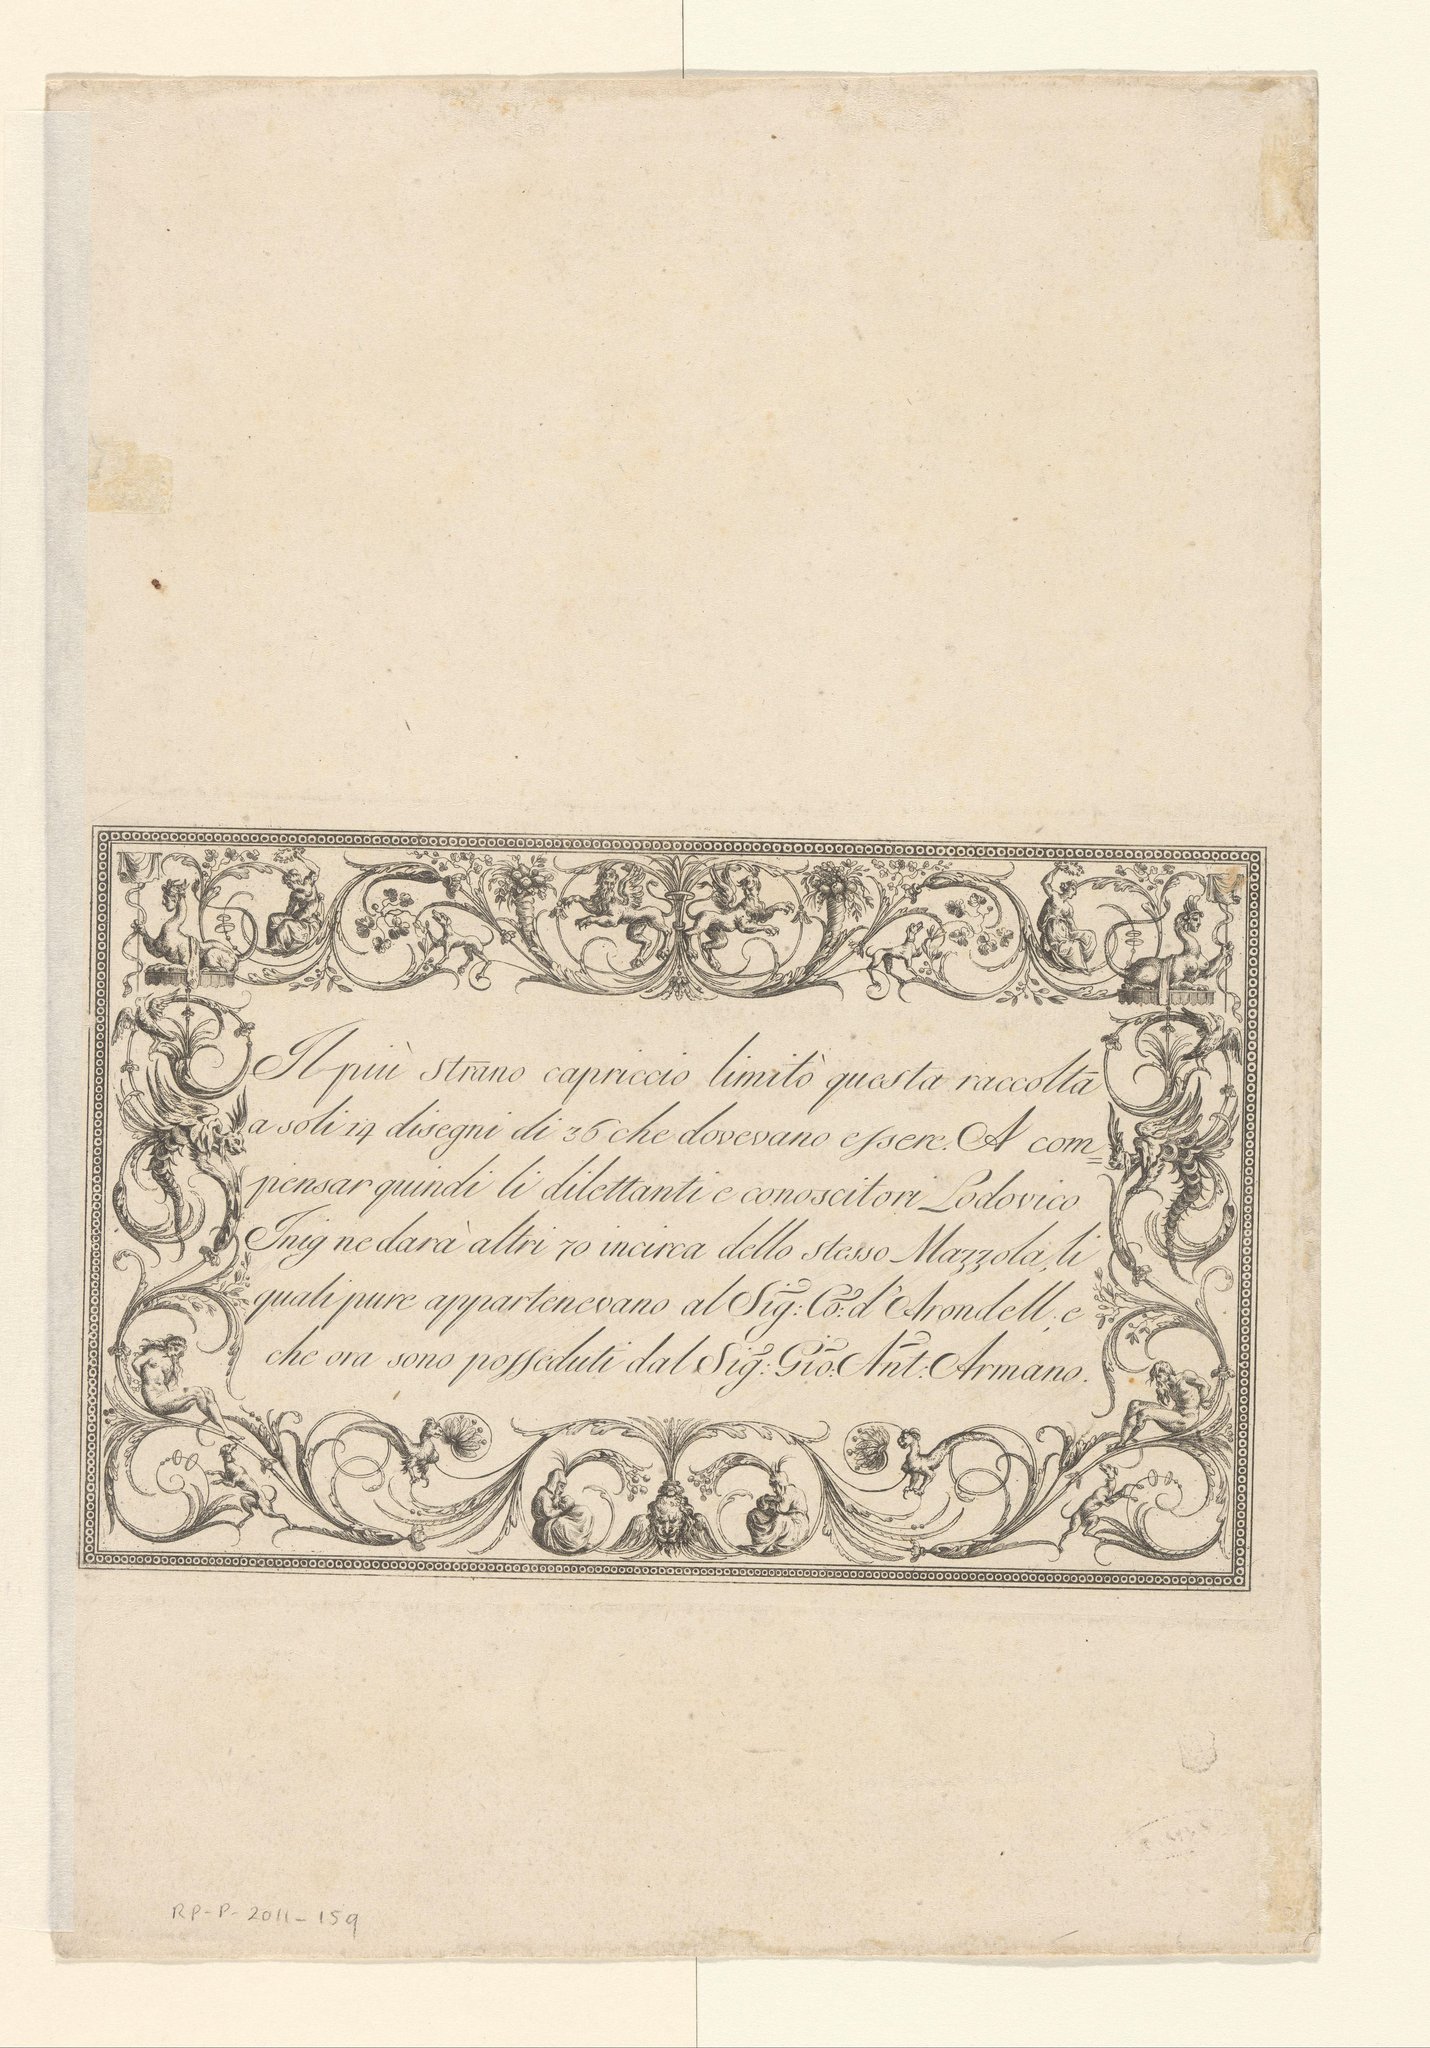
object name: print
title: Cartouche met tekst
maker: Anonymous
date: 1780-1841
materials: paper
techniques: etching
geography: italy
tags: painter, print maker, draughtsman, parmigianino, 'natura' (allegorical figure or scene; or as diana of ephesus, with many breasts); 'natura' (ripa), 'pictura', symbolic representations, allegories and emblems ~ painting; 'pittura' (ripa), tools, implements of painter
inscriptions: collector's mark: Lugt 2228, collector's mark: Lugt 2760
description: Een cartouche met groteske ornamentiek en een gedrukte Italiaanse tekst met betrekking tot de tekeningen van Parmigianino in de collectie Arundel en Giovanni Antonio Armano.